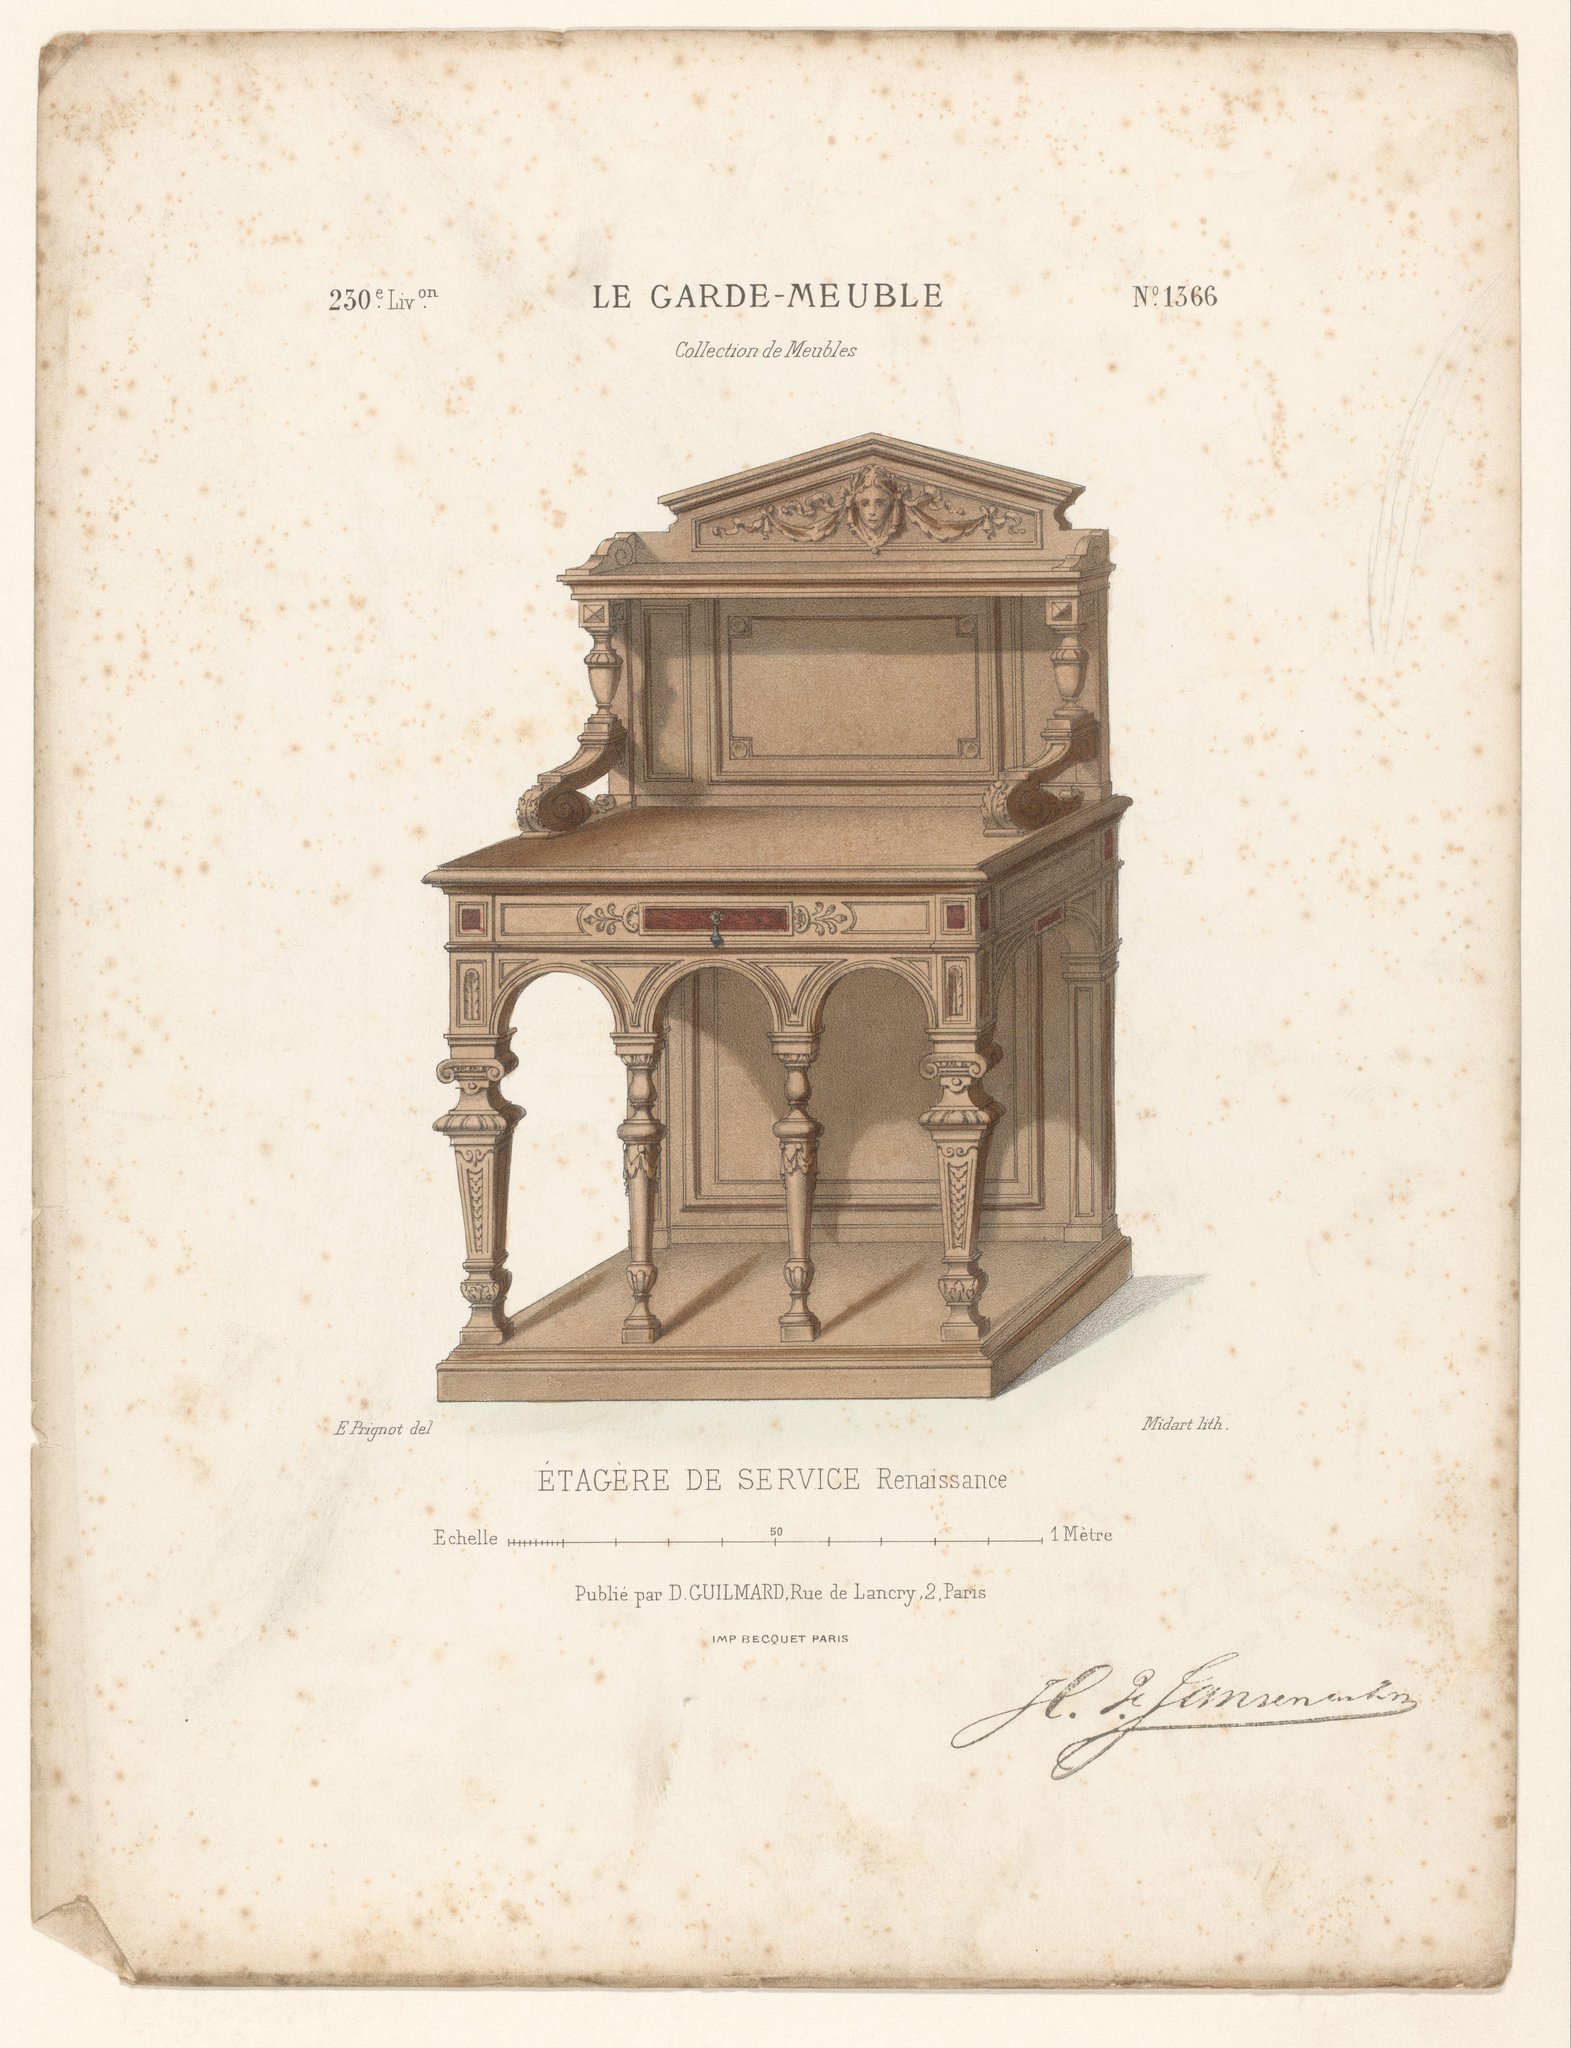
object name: print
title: Le garde-meuble / Collection de Meubles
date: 1839-1885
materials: paper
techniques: hand coloring, lithograph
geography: paris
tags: furniture for storage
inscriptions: stamp: ‘H.F. Jansen en Zn’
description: Ieder Livraison in de serie Le Garde-Meuble bevat negen platen: drie 'sièges' (zitmeubels), drie 'meubles' (diverse meubels zoals tafels en kasten) en drie 'tentures' (gordijnen en draperieën).